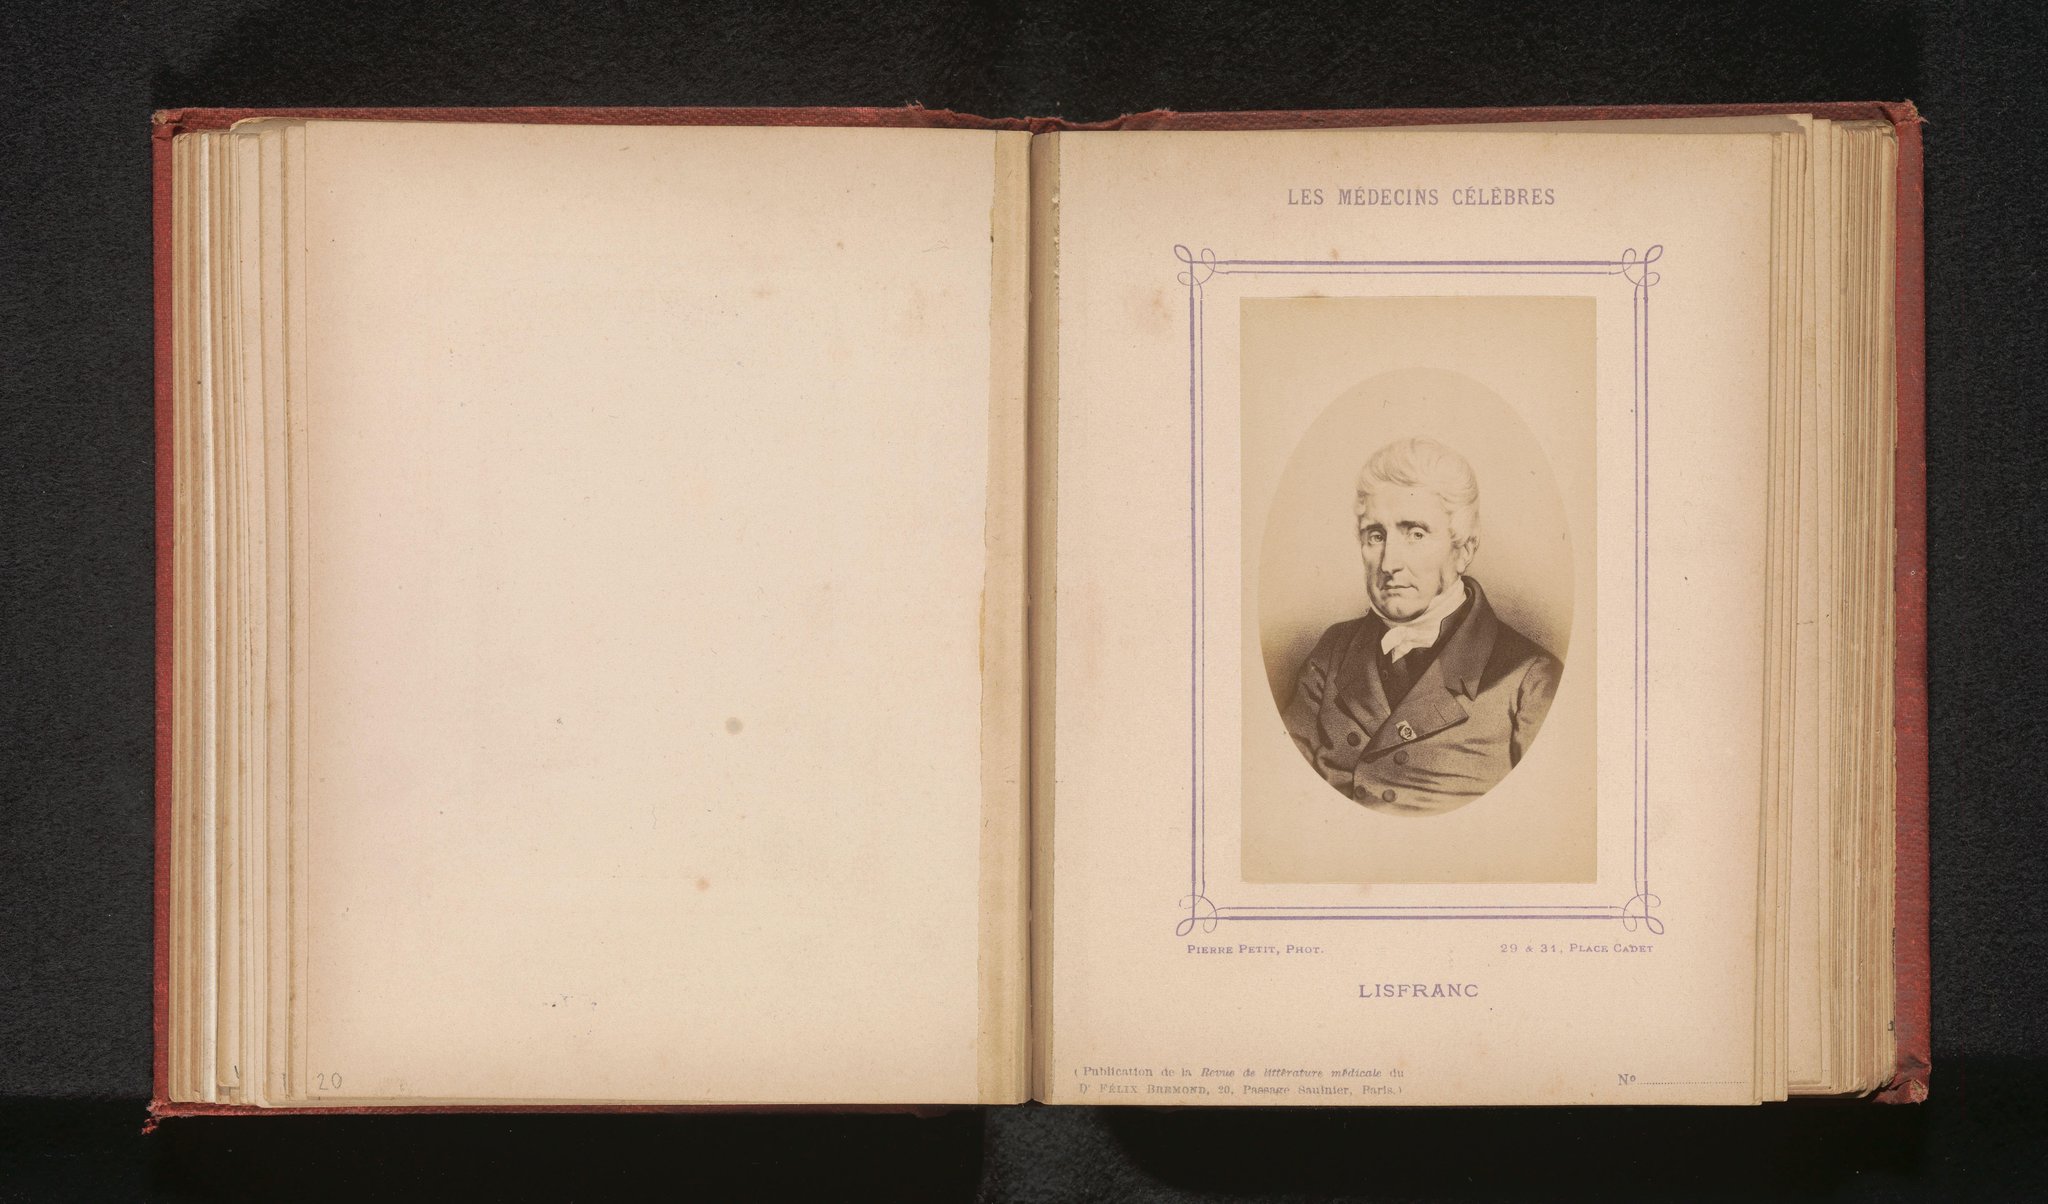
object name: photograph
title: Fotoreproductie van een portret van Jacques Lisfranc de St. Martin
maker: pierre petit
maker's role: fotograaf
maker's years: 1832-1909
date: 1871-1879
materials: paper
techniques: albumen print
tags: paris, adult man, historical persons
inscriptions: inscription: ‘(Publication de la Revue de litterature médicale, du/ D. Félix Bremond/ 20, Passage Saulnier, Paris./ No.]’